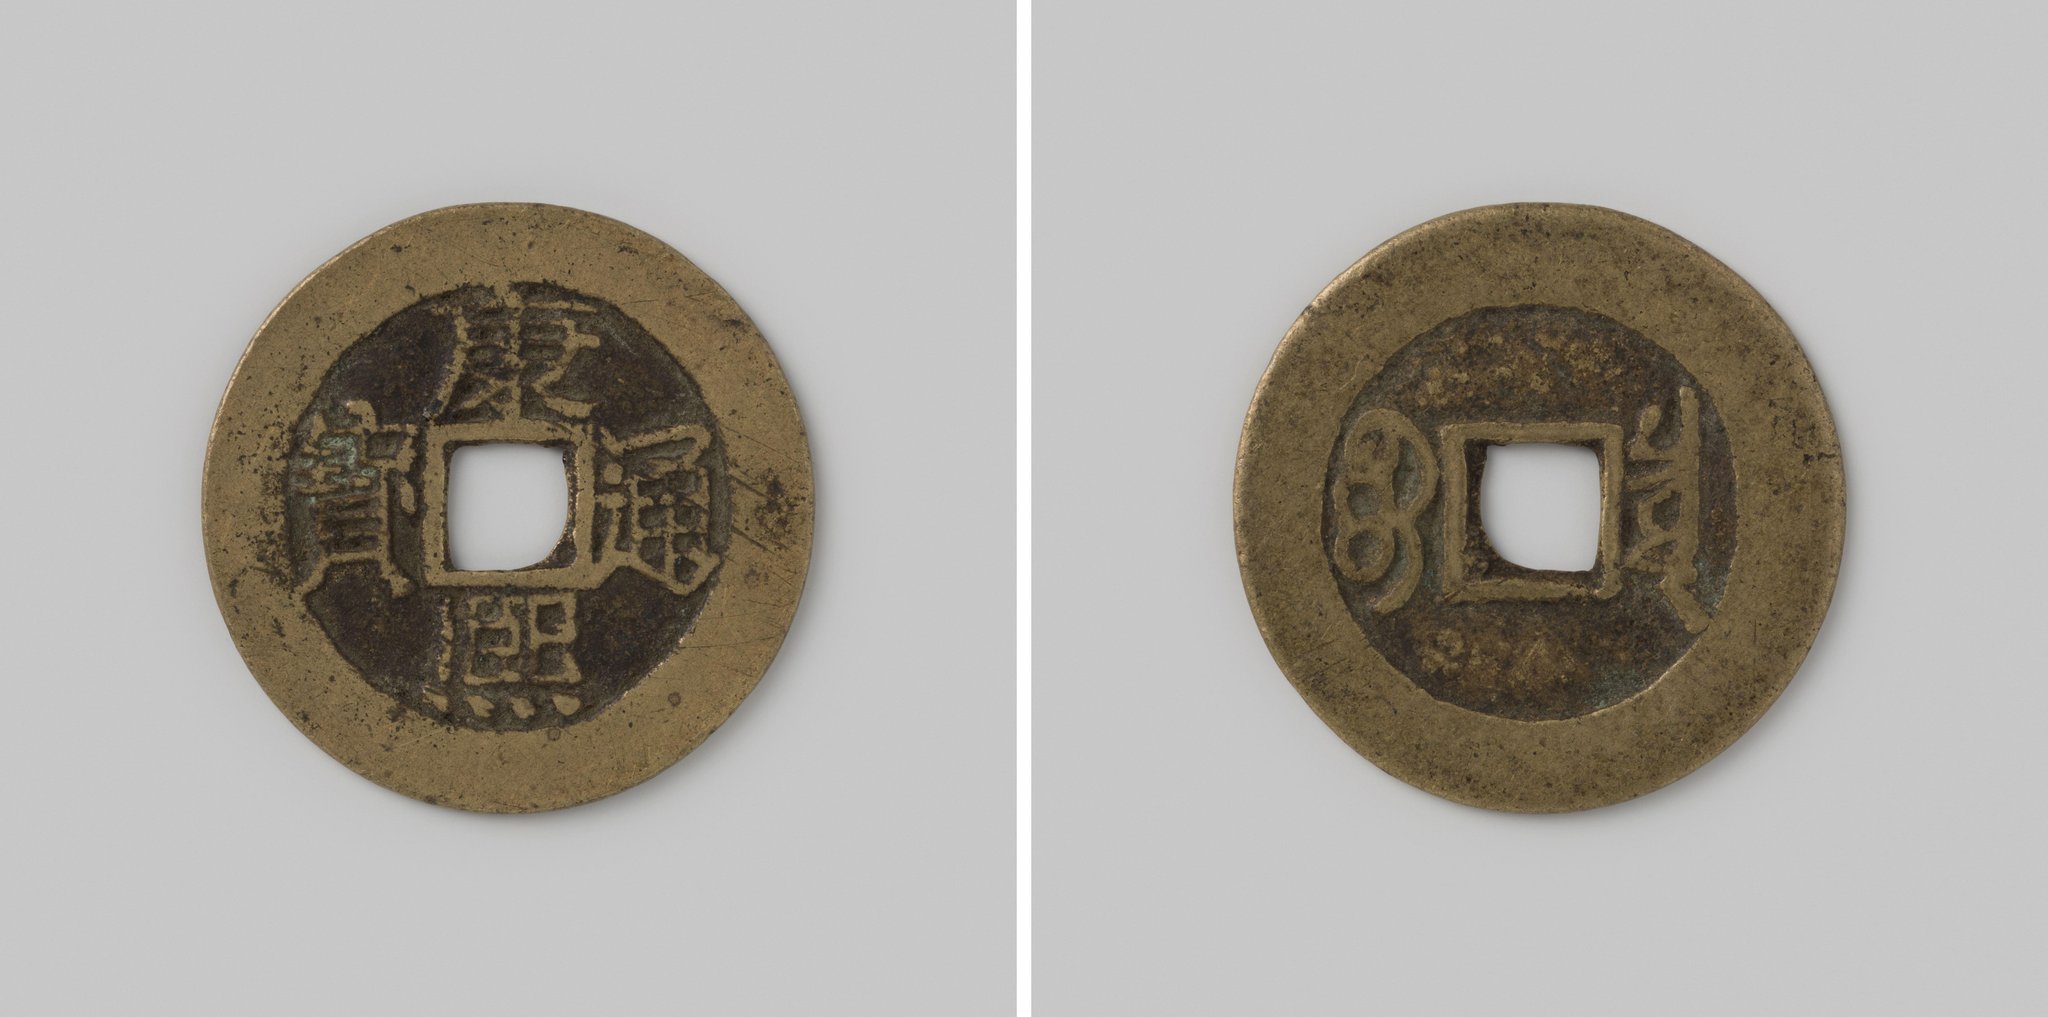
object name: coin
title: Cash van het keizerrijk China van keizer Sheng Tsu onder de regeringsnaam K ang-Hsi,1662 -1722, in opdracht van het Departement van Financiën te Bejing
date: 1662-1722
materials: copper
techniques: casting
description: Koperen munt. Voorzijde: binnen brede opstaande rand rondom vierkante uitsparing in het midden vier kruisgewijze geplaatste Chinese tekens, waarvan twee met de betekenis: K ang hsi. Keerzijde: binnen brede opstaande rand ter weerszijden van vierkante uitsparing in het midden twee Chinese tekens, waarbij het rechter teken met de betekenis in Manchu: Chuan = Financiën.